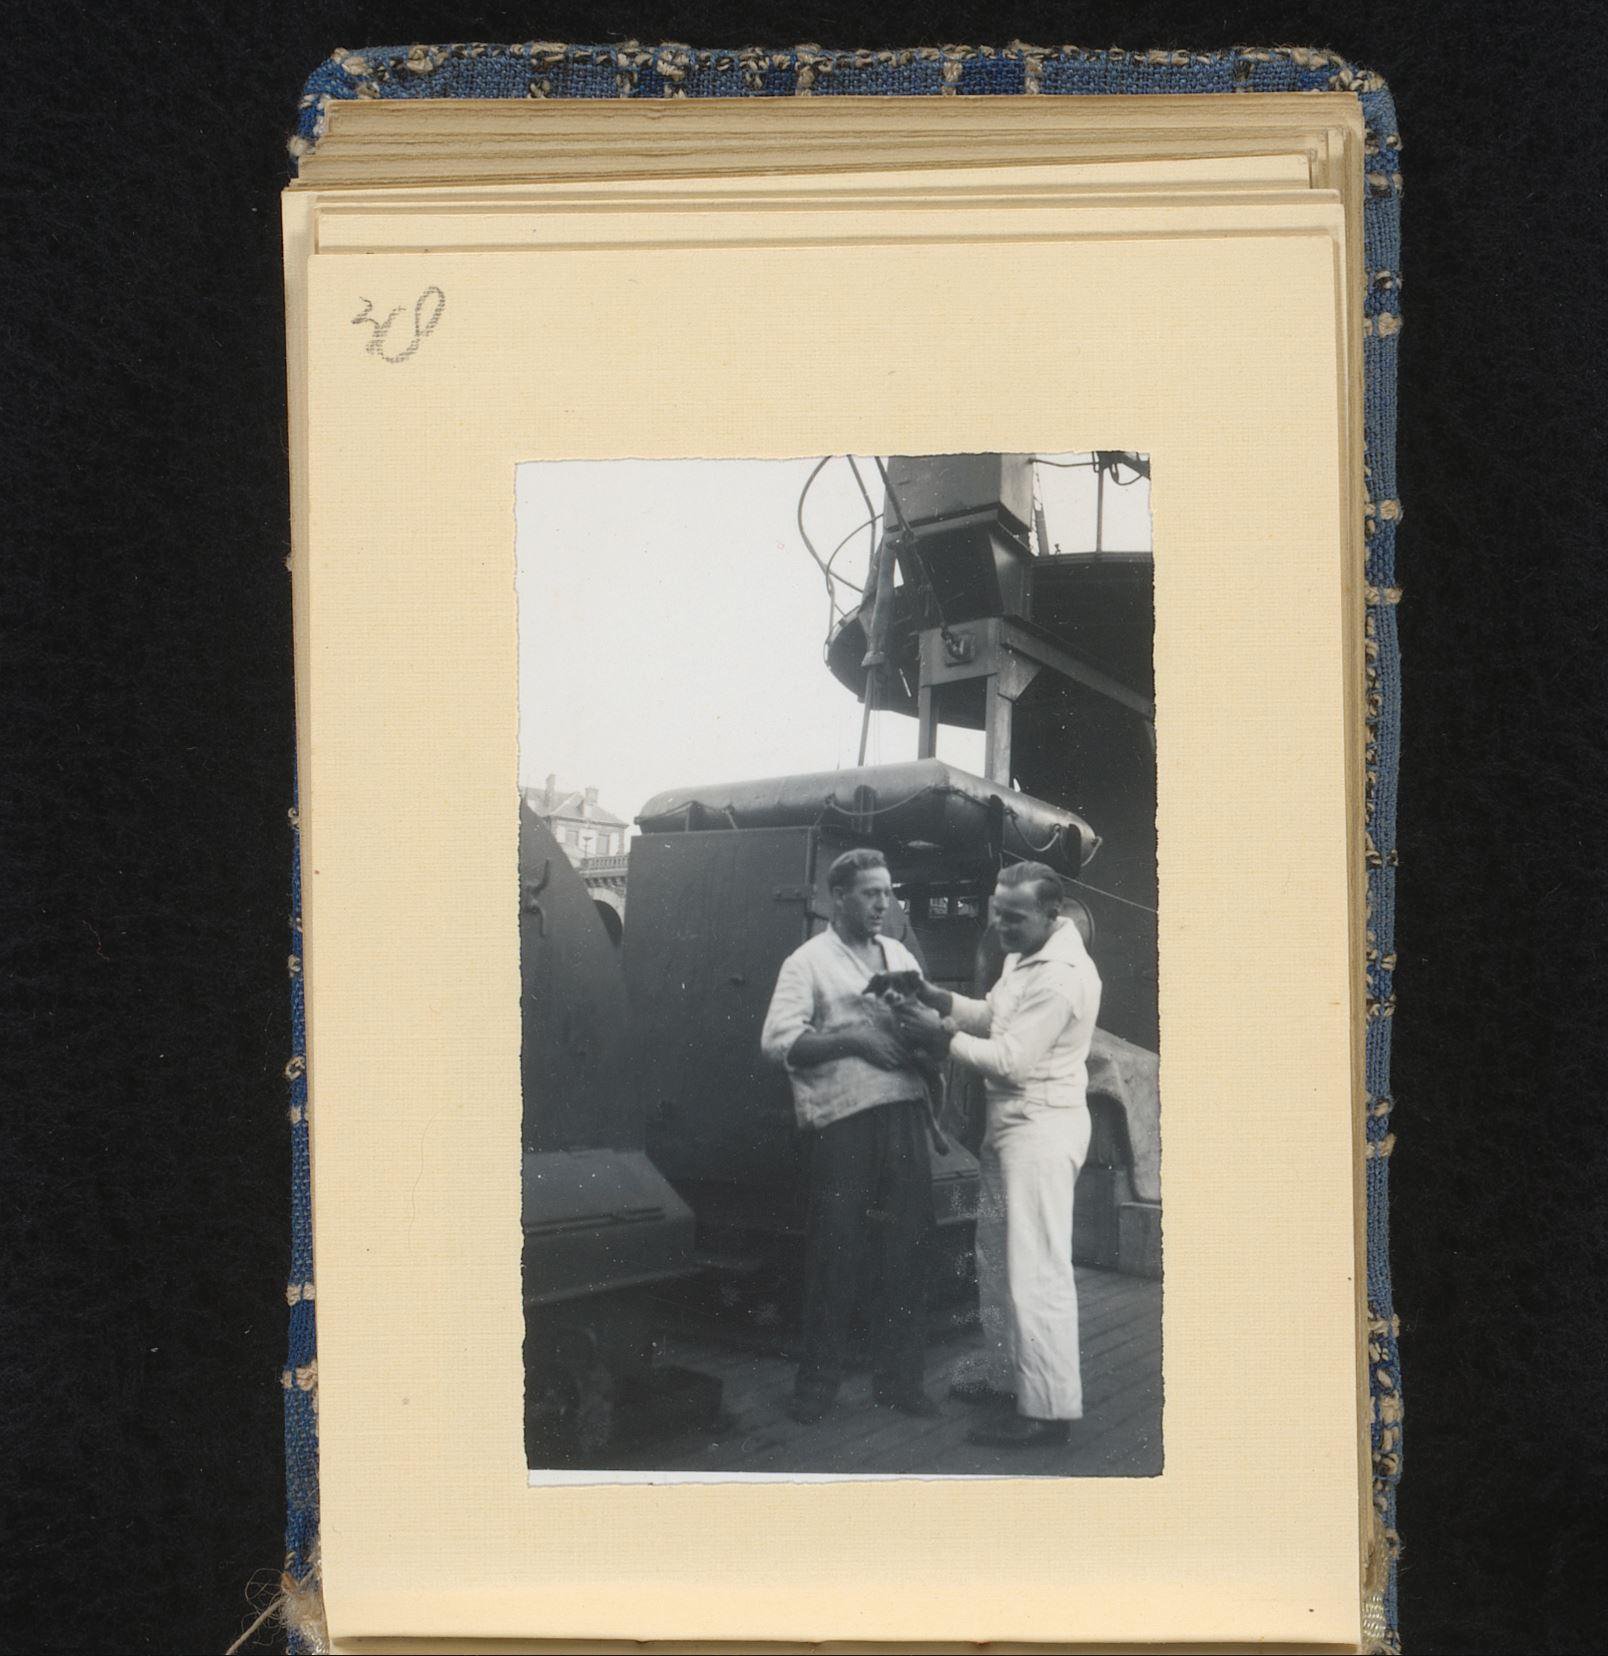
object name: photograph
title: Matrozen met hond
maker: Anonymous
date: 1940-1943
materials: photographic support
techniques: gelatin silver print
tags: camouflage, sailor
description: Twee Duitse matrozen met een hond, op het dek van een schip. Onderdeel van het fotoalbum over de Kriegsmarine 1940-1943.